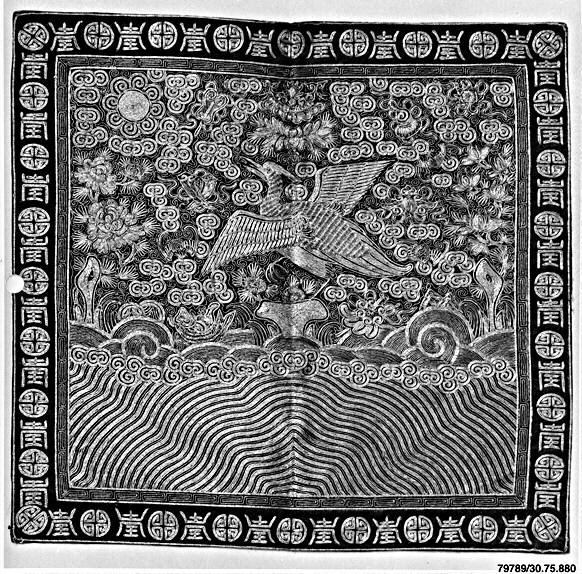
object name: rank badge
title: Rank Badge with Egret (?)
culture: chinese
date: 1801-1900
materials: metal thread, silk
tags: cranes